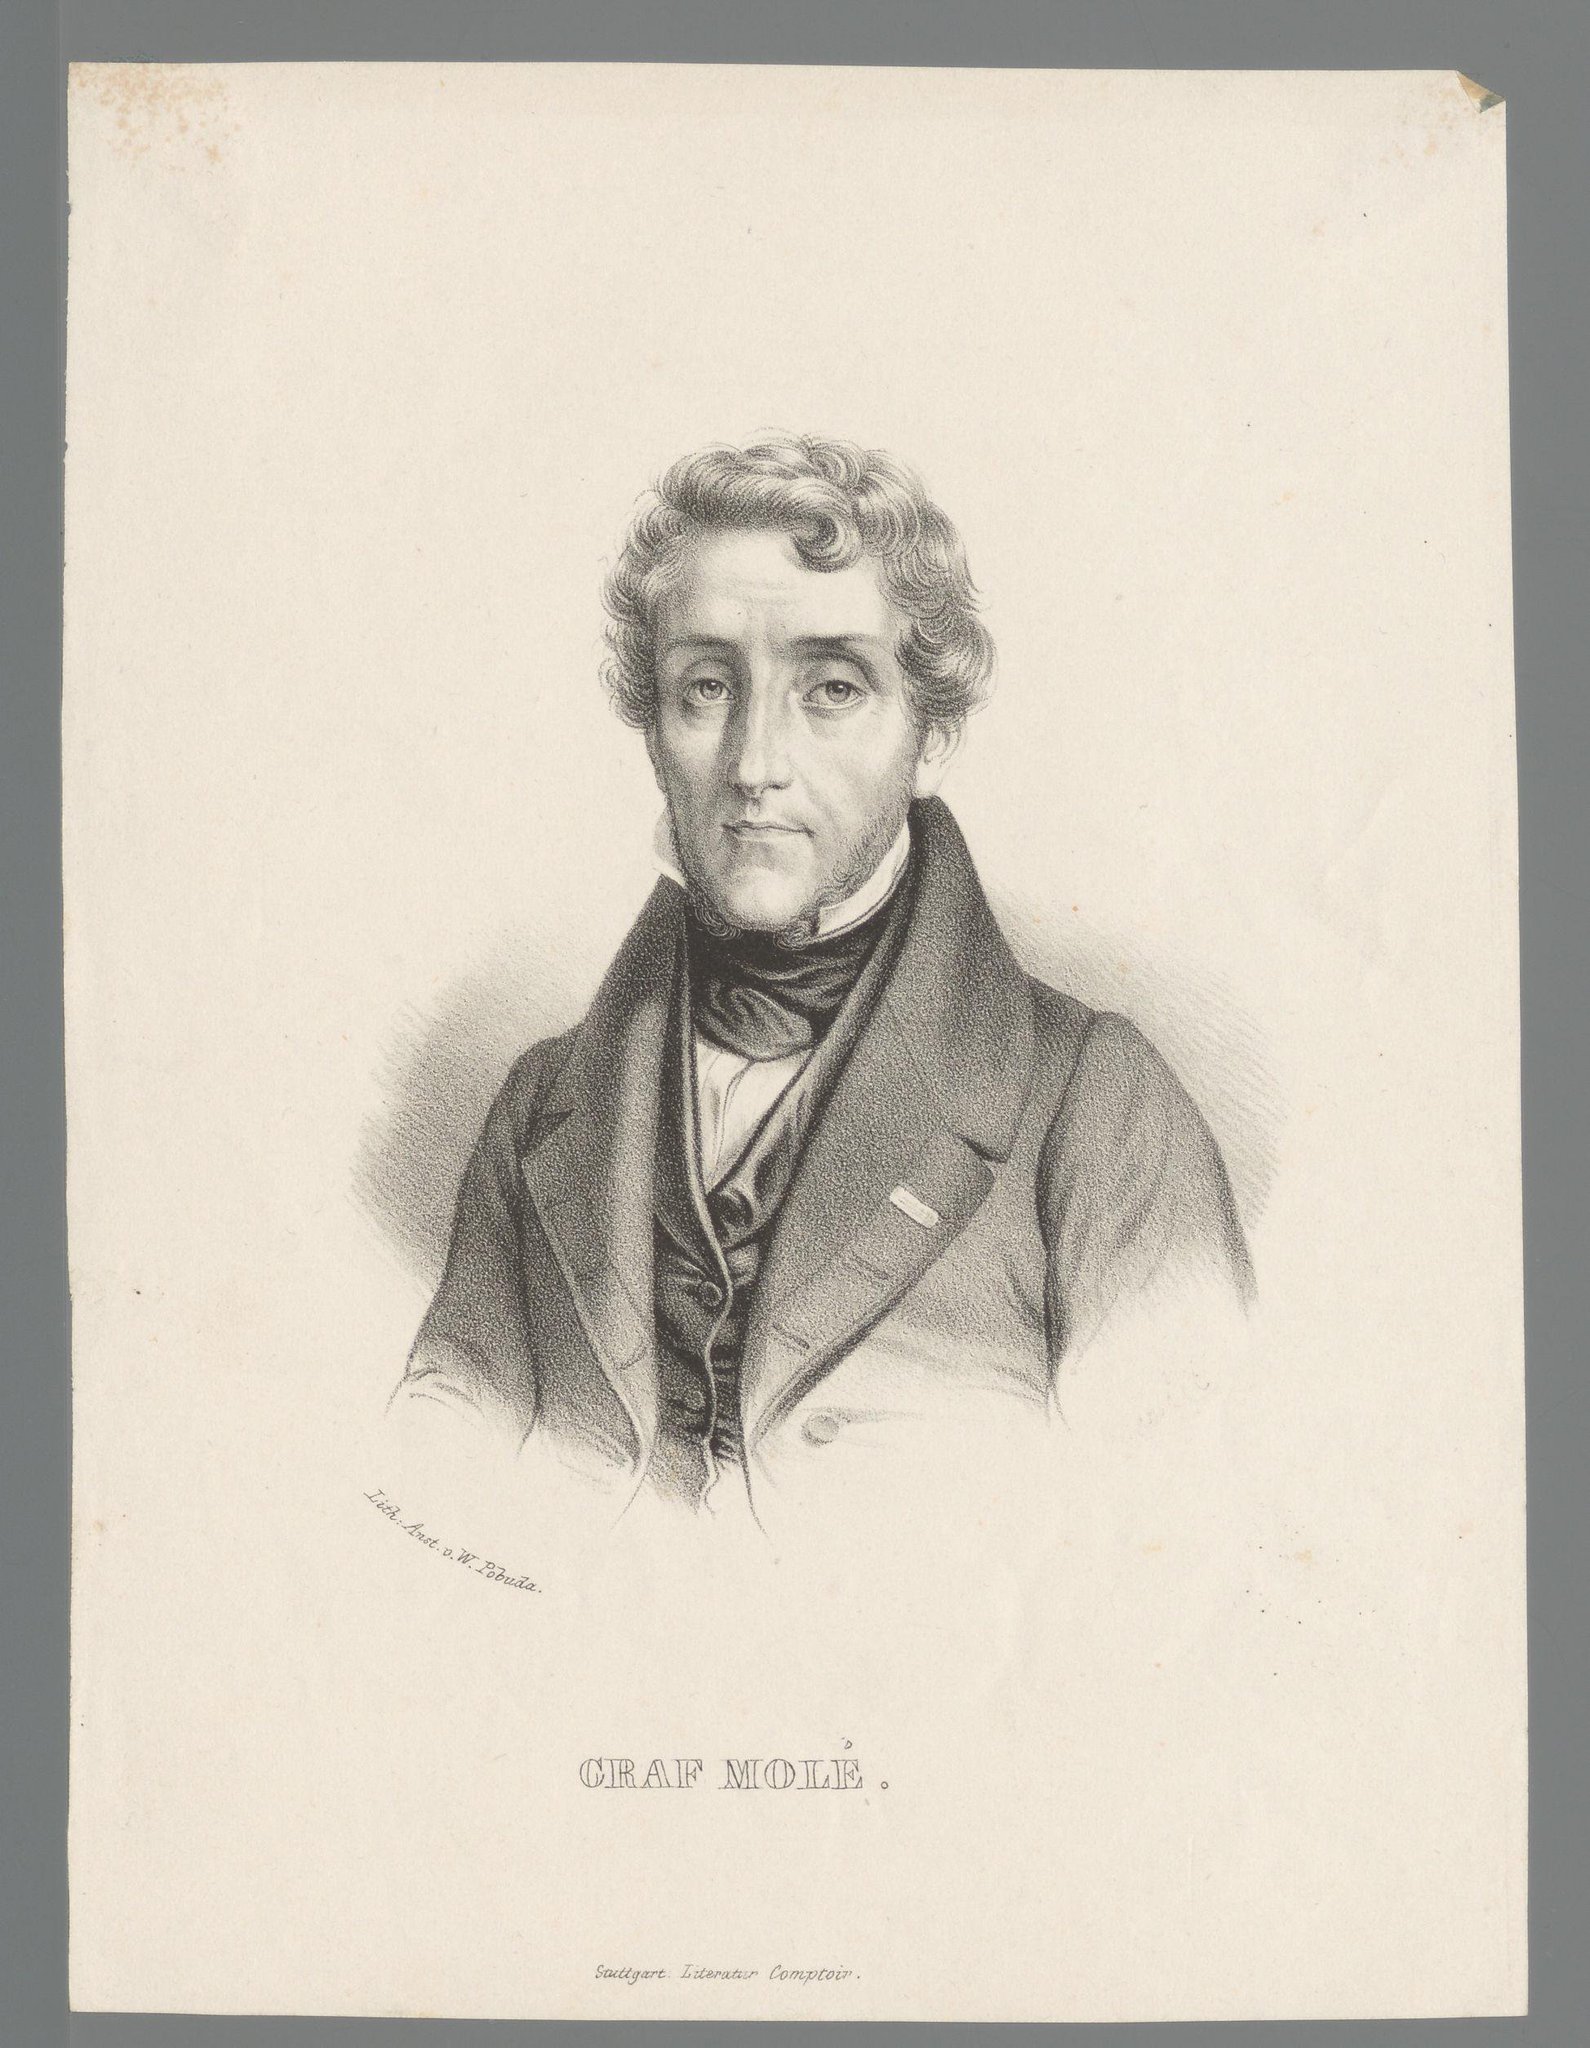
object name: print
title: Portret van Louis-Mathieu Molé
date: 1823-1845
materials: paper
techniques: lithograph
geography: stuttgart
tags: paris, adult man, historical persons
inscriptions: collector's mark: Lugt 2228